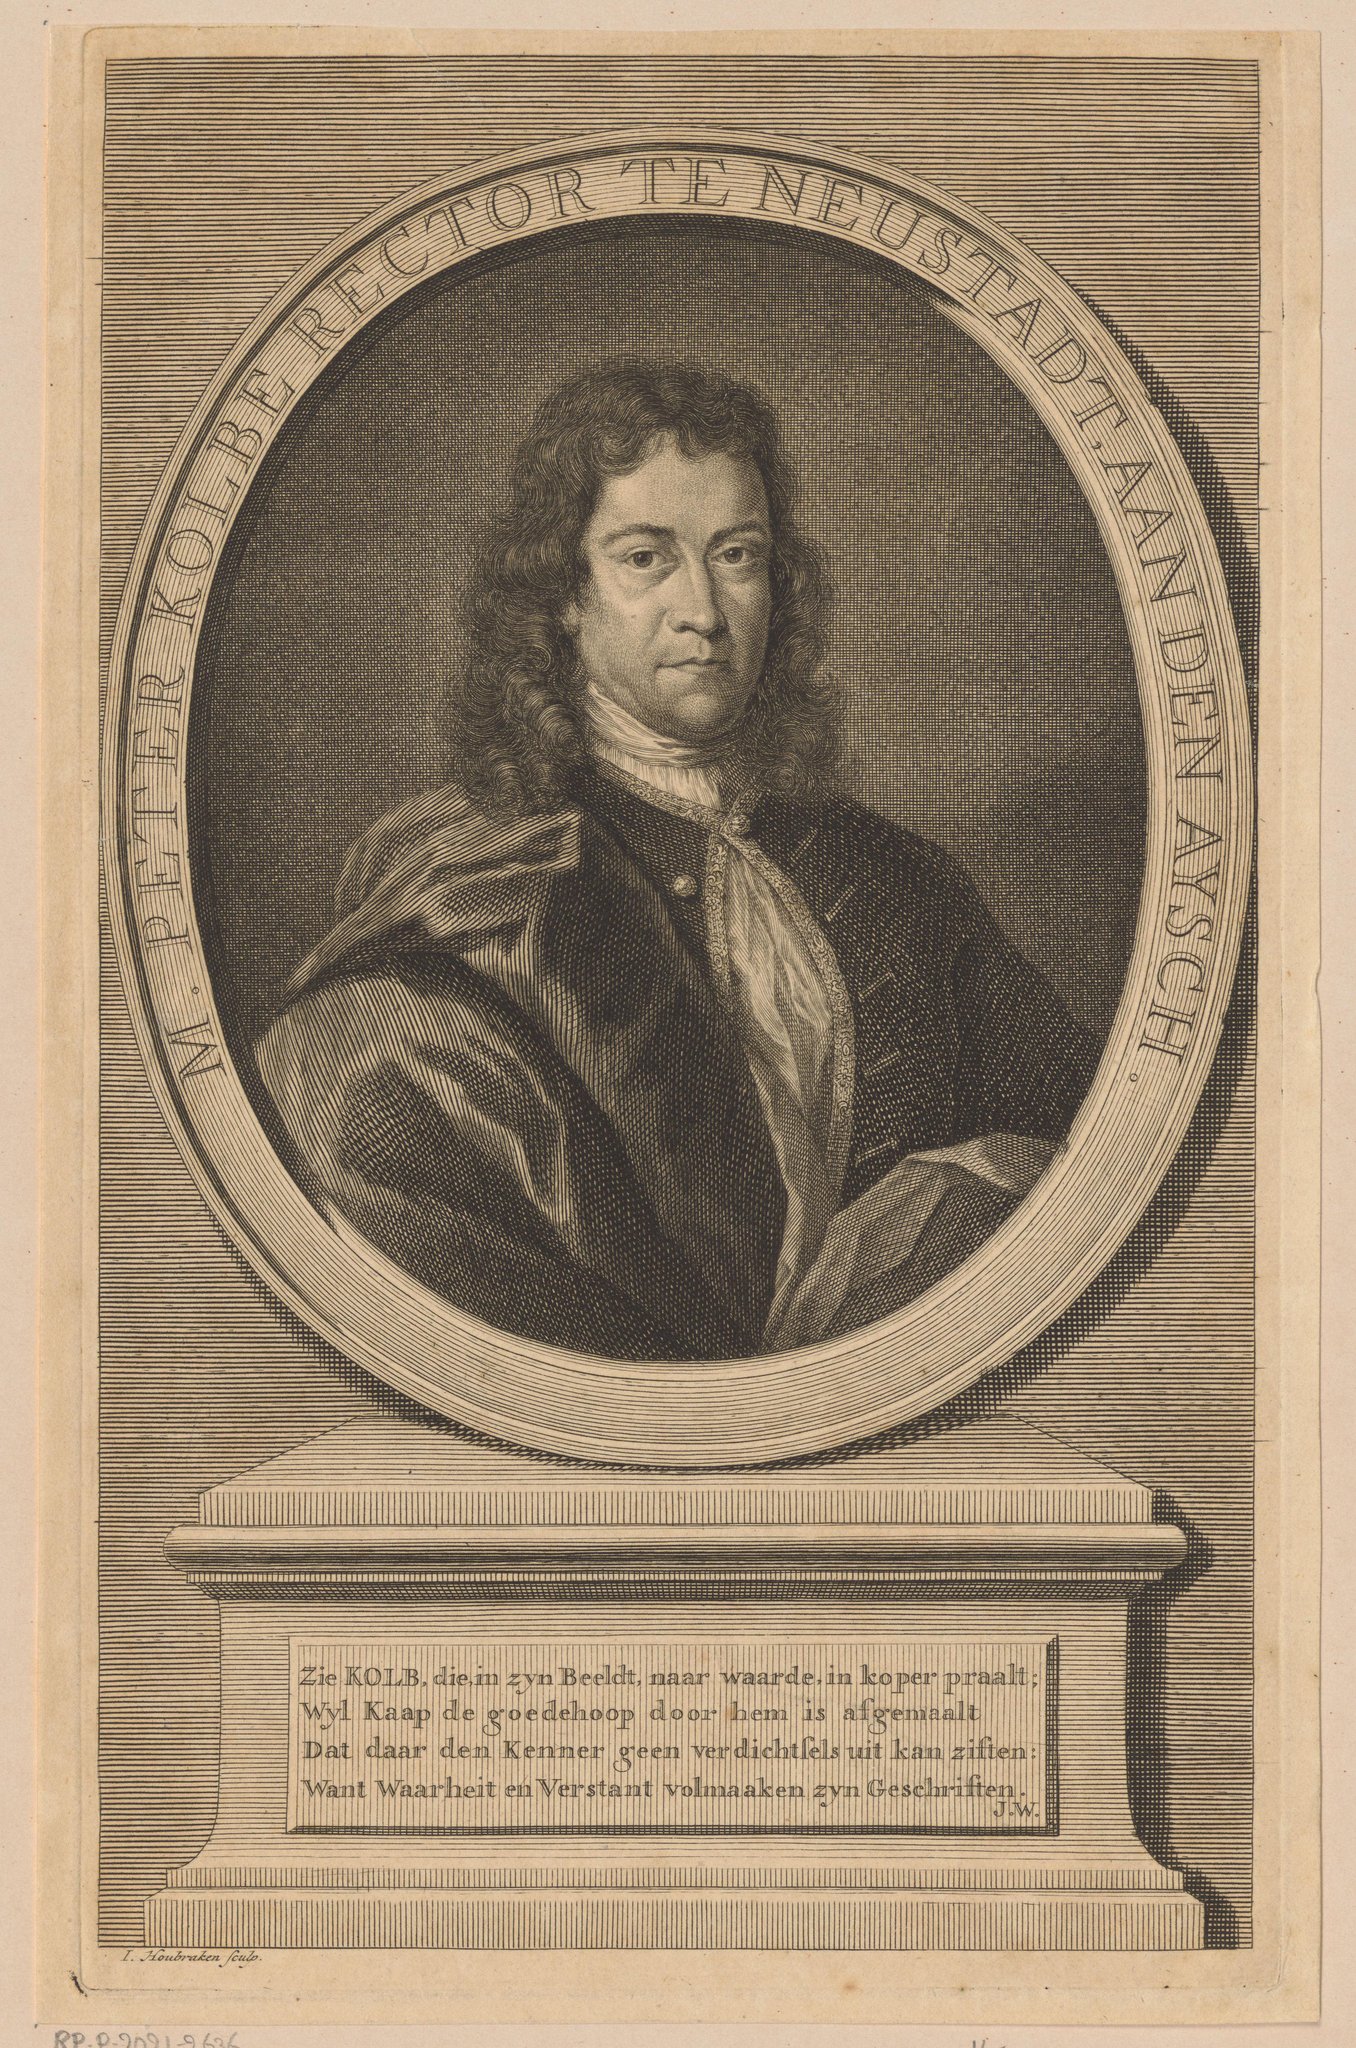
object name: print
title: Portret van Peter Kolb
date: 1727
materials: paper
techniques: engraving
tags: historical persons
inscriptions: watermark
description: Prent mogelijk uit: Kolb, Peter. Naaukeurige en uitvoerige beschryving van de Kaap de Goede Hoop. Amsterdam: Balthazar Lakeman, 1727, dl. 1.